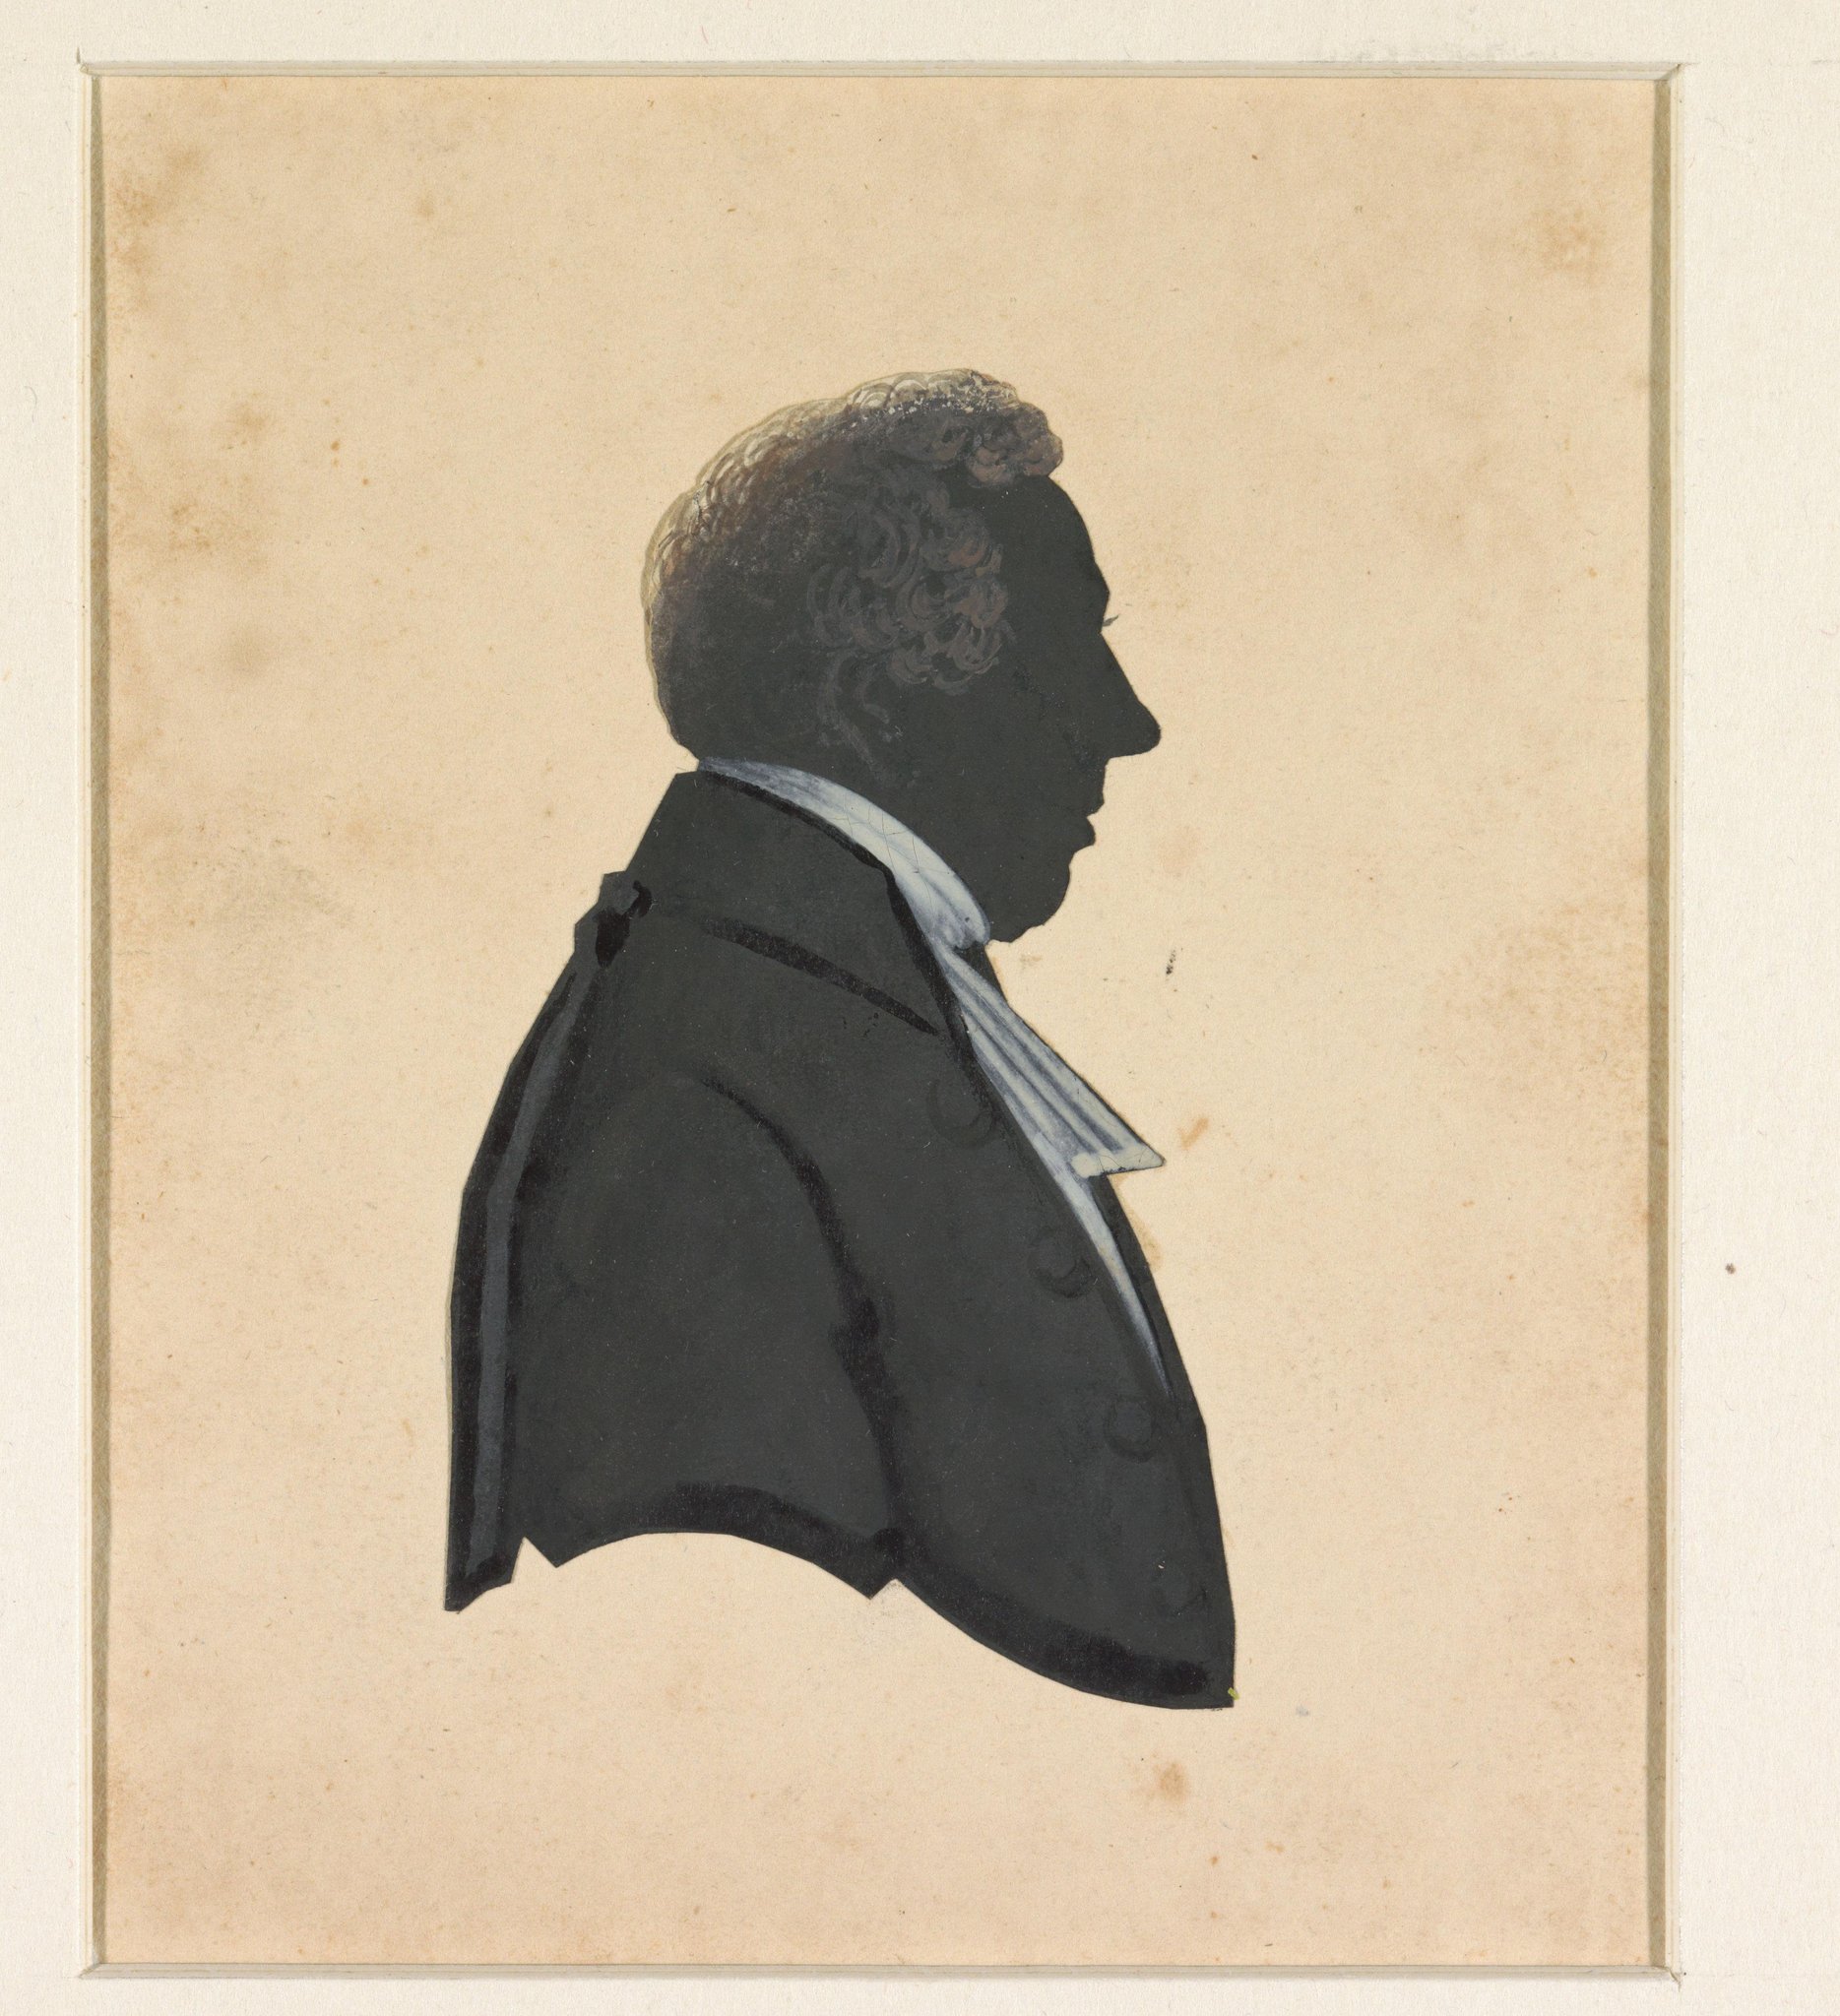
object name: cut paper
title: Silhouet van een predikant, naar rechts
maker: Anonymous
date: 1800-1900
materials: paint, paper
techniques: brush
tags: anonymous historical person portrayed alone, male sex; man